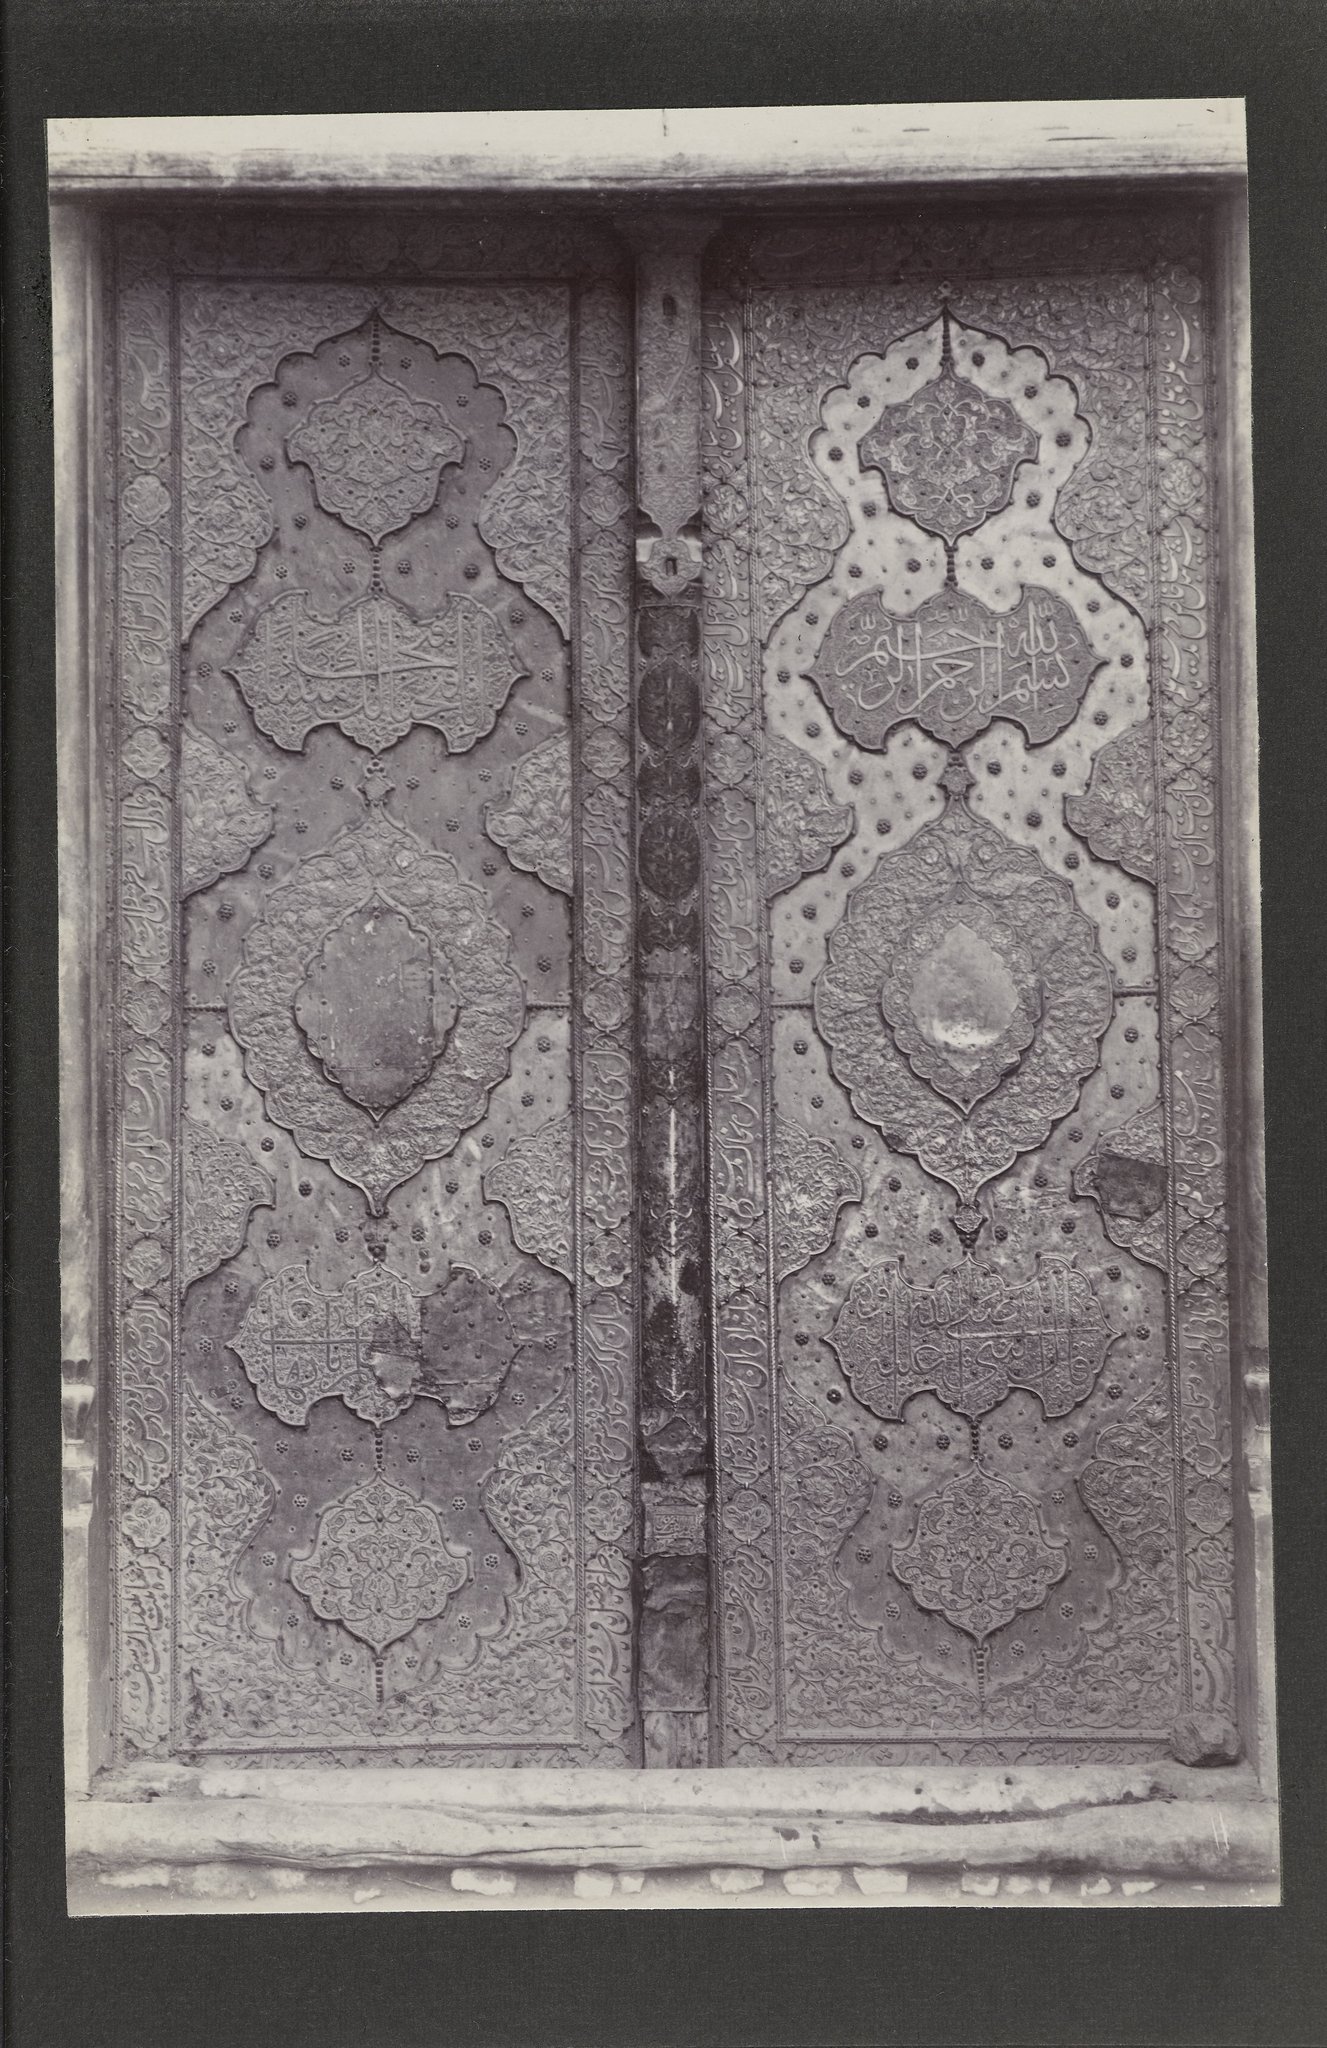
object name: photograph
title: Detail van moskee (?) in Perzië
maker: a.g.a. van eelde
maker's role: engineer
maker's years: 1862-1950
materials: cardboard, paper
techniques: gelatin silver print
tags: iran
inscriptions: number: ‘50.’